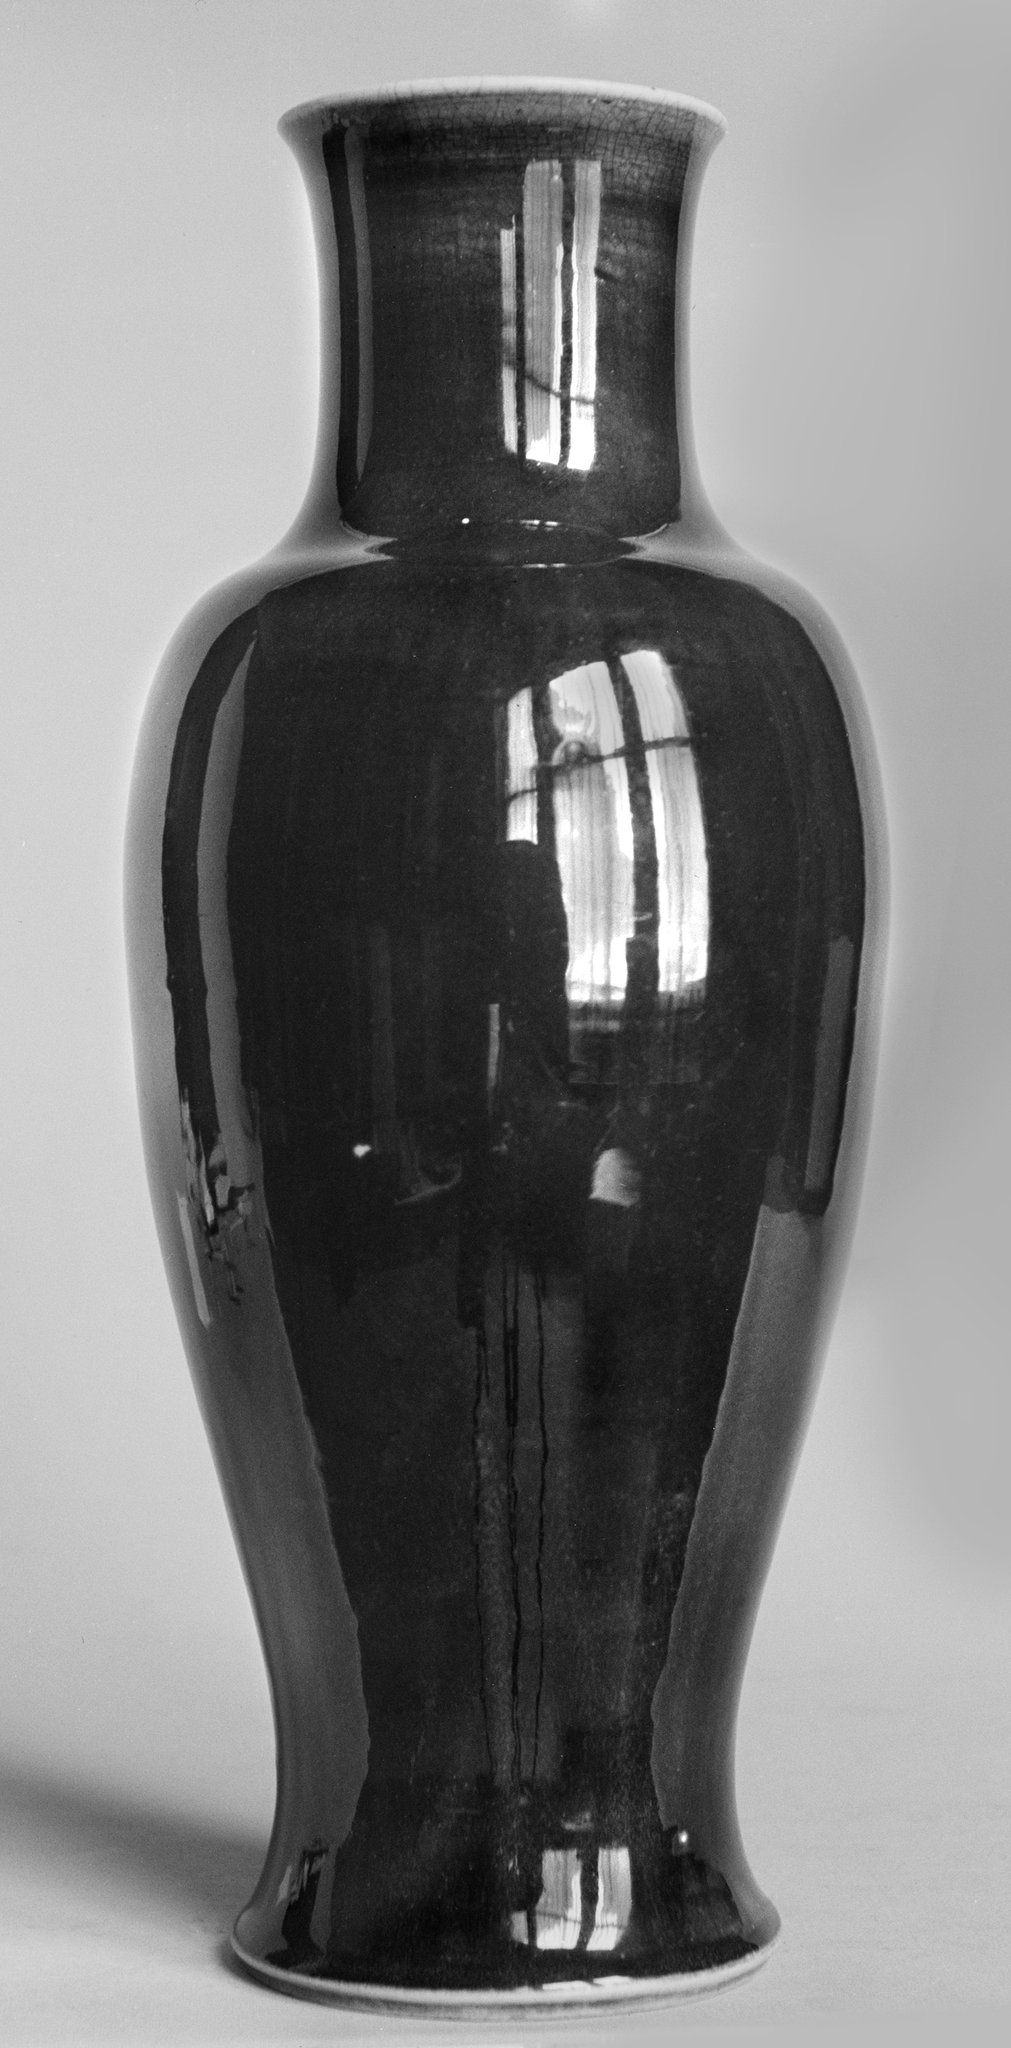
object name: vase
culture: chinese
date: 1662-1722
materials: porcelain